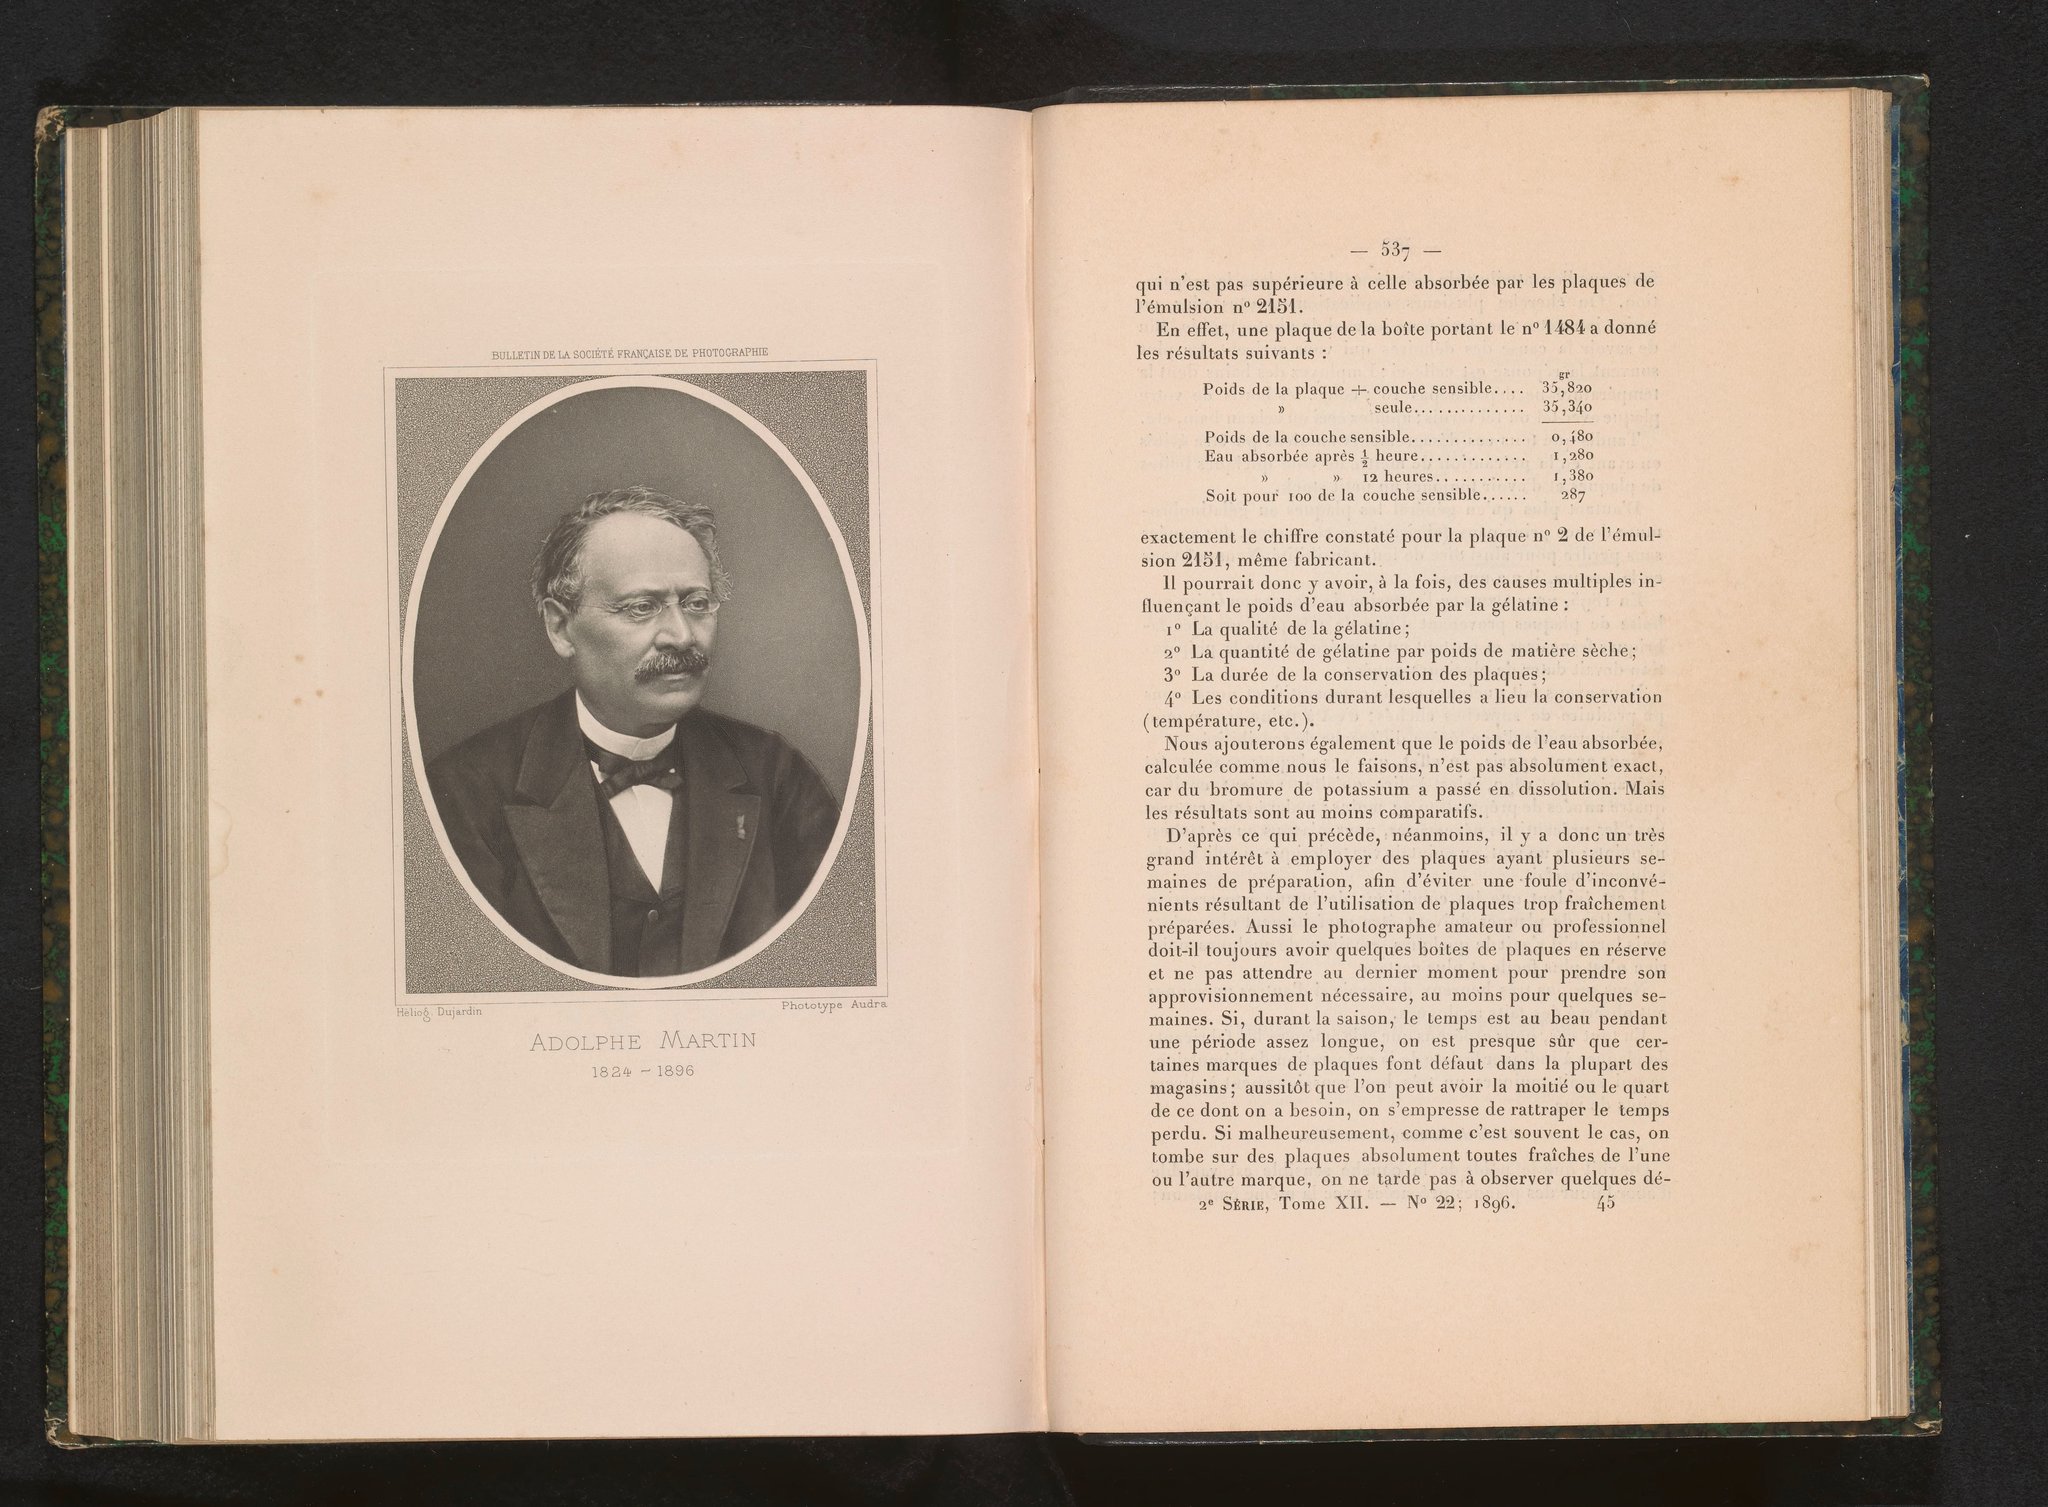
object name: page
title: Adolphe Martin 1824-1896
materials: paper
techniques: photoaquatint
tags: historical persons (portraits and scenes from the life)